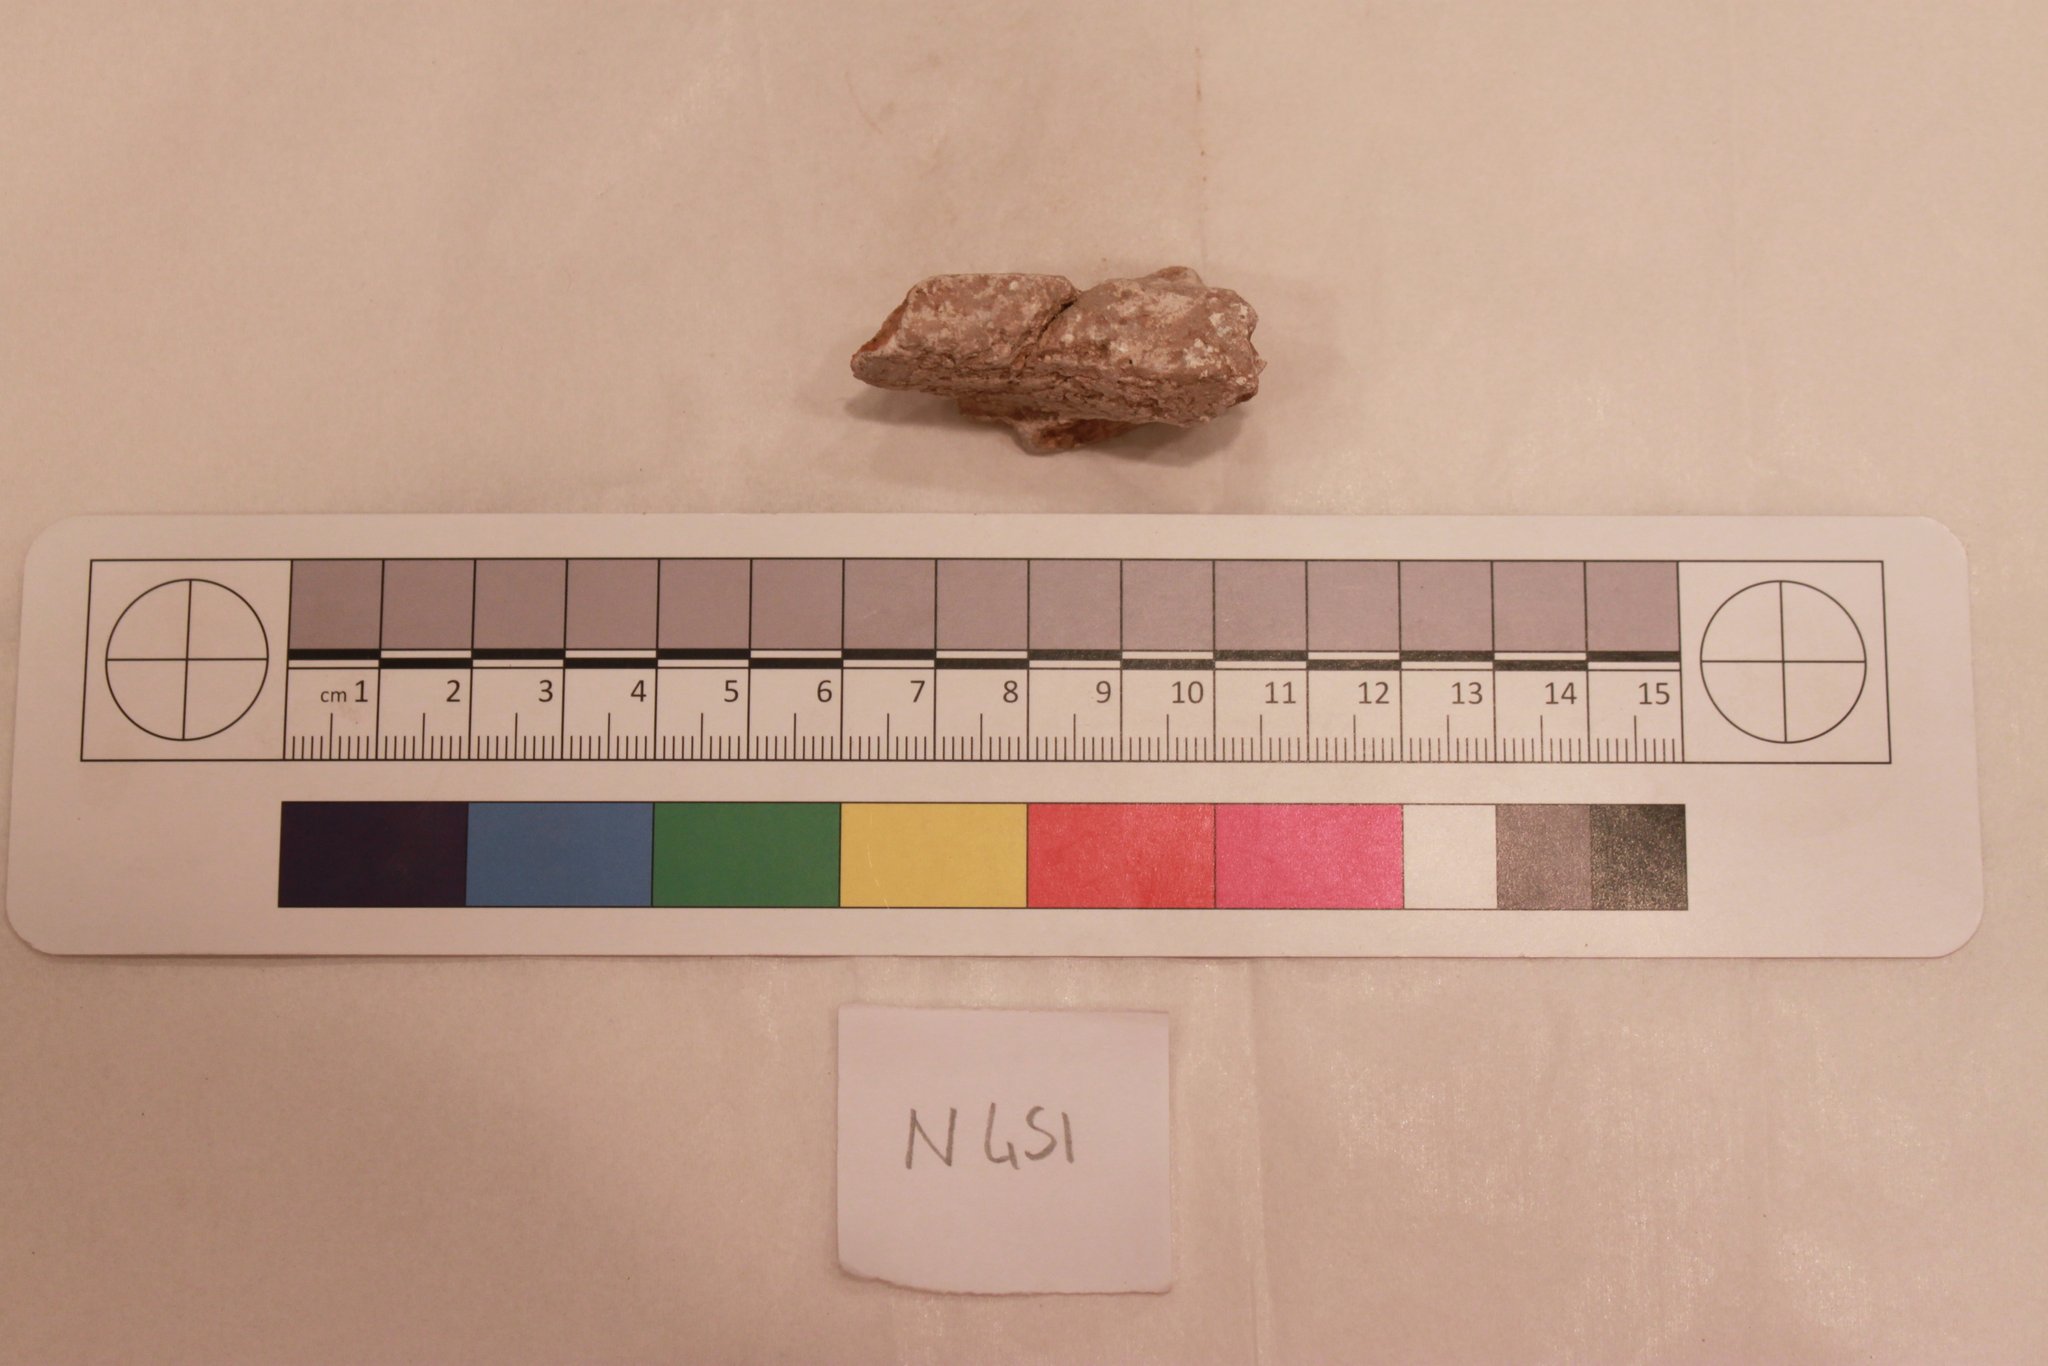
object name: fragment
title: Stucco Fragment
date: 701-1200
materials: plaster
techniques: carving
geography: iran